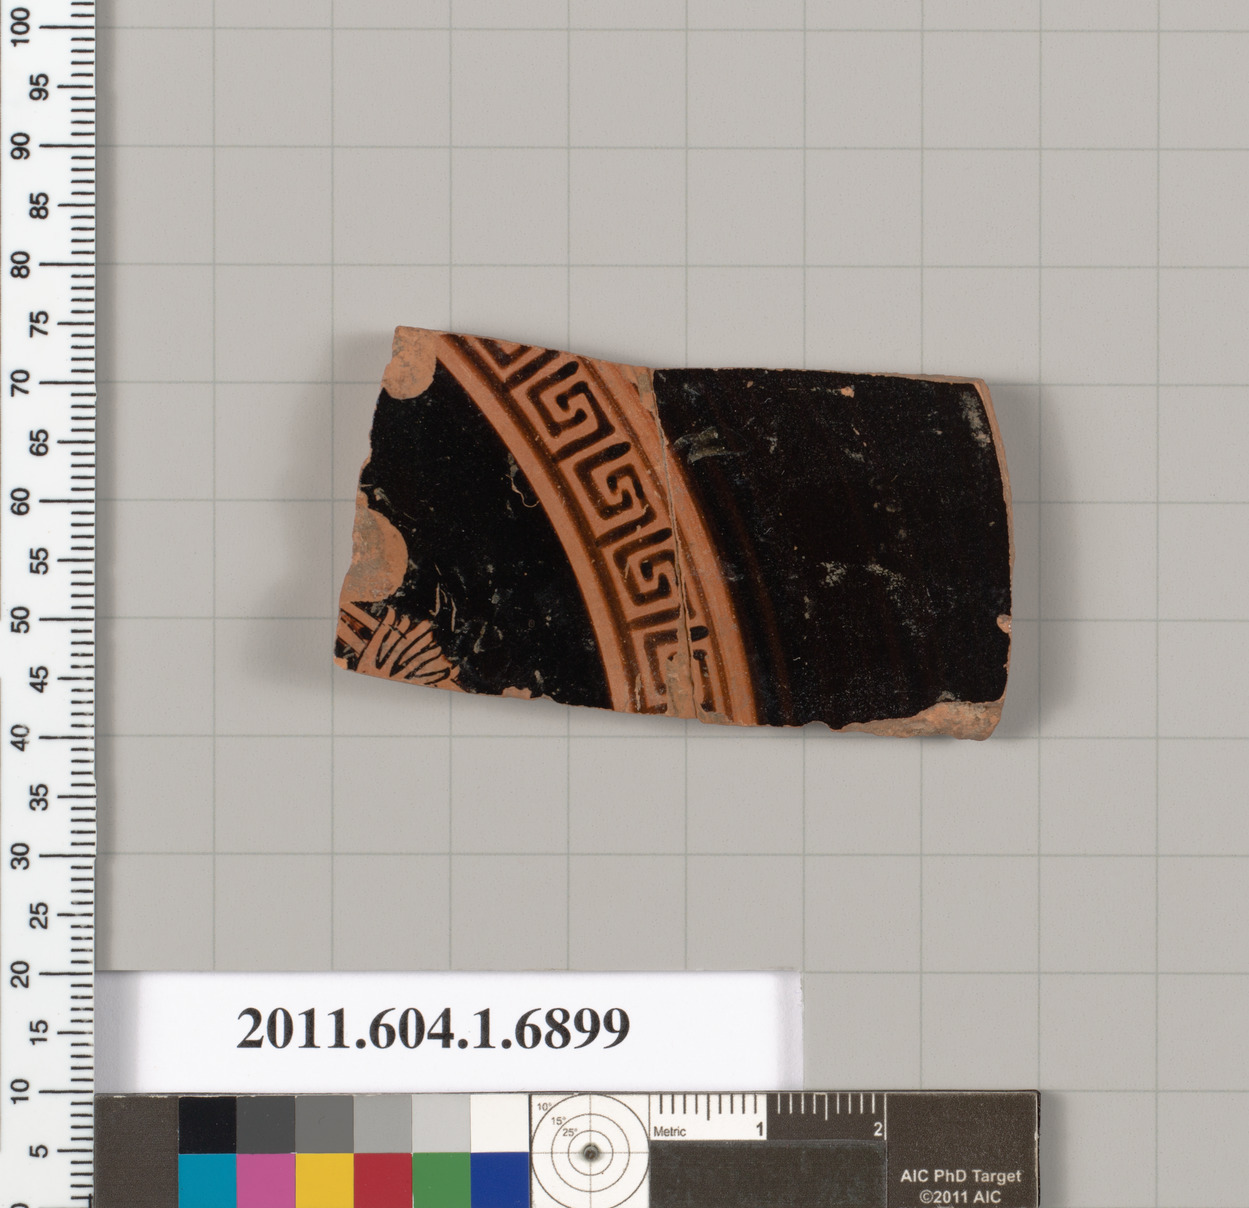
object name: kylix fragment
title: Terracotta fragment of a kylix (drinking cup)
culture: greek, attic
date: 490-470 BCE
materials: terracotta